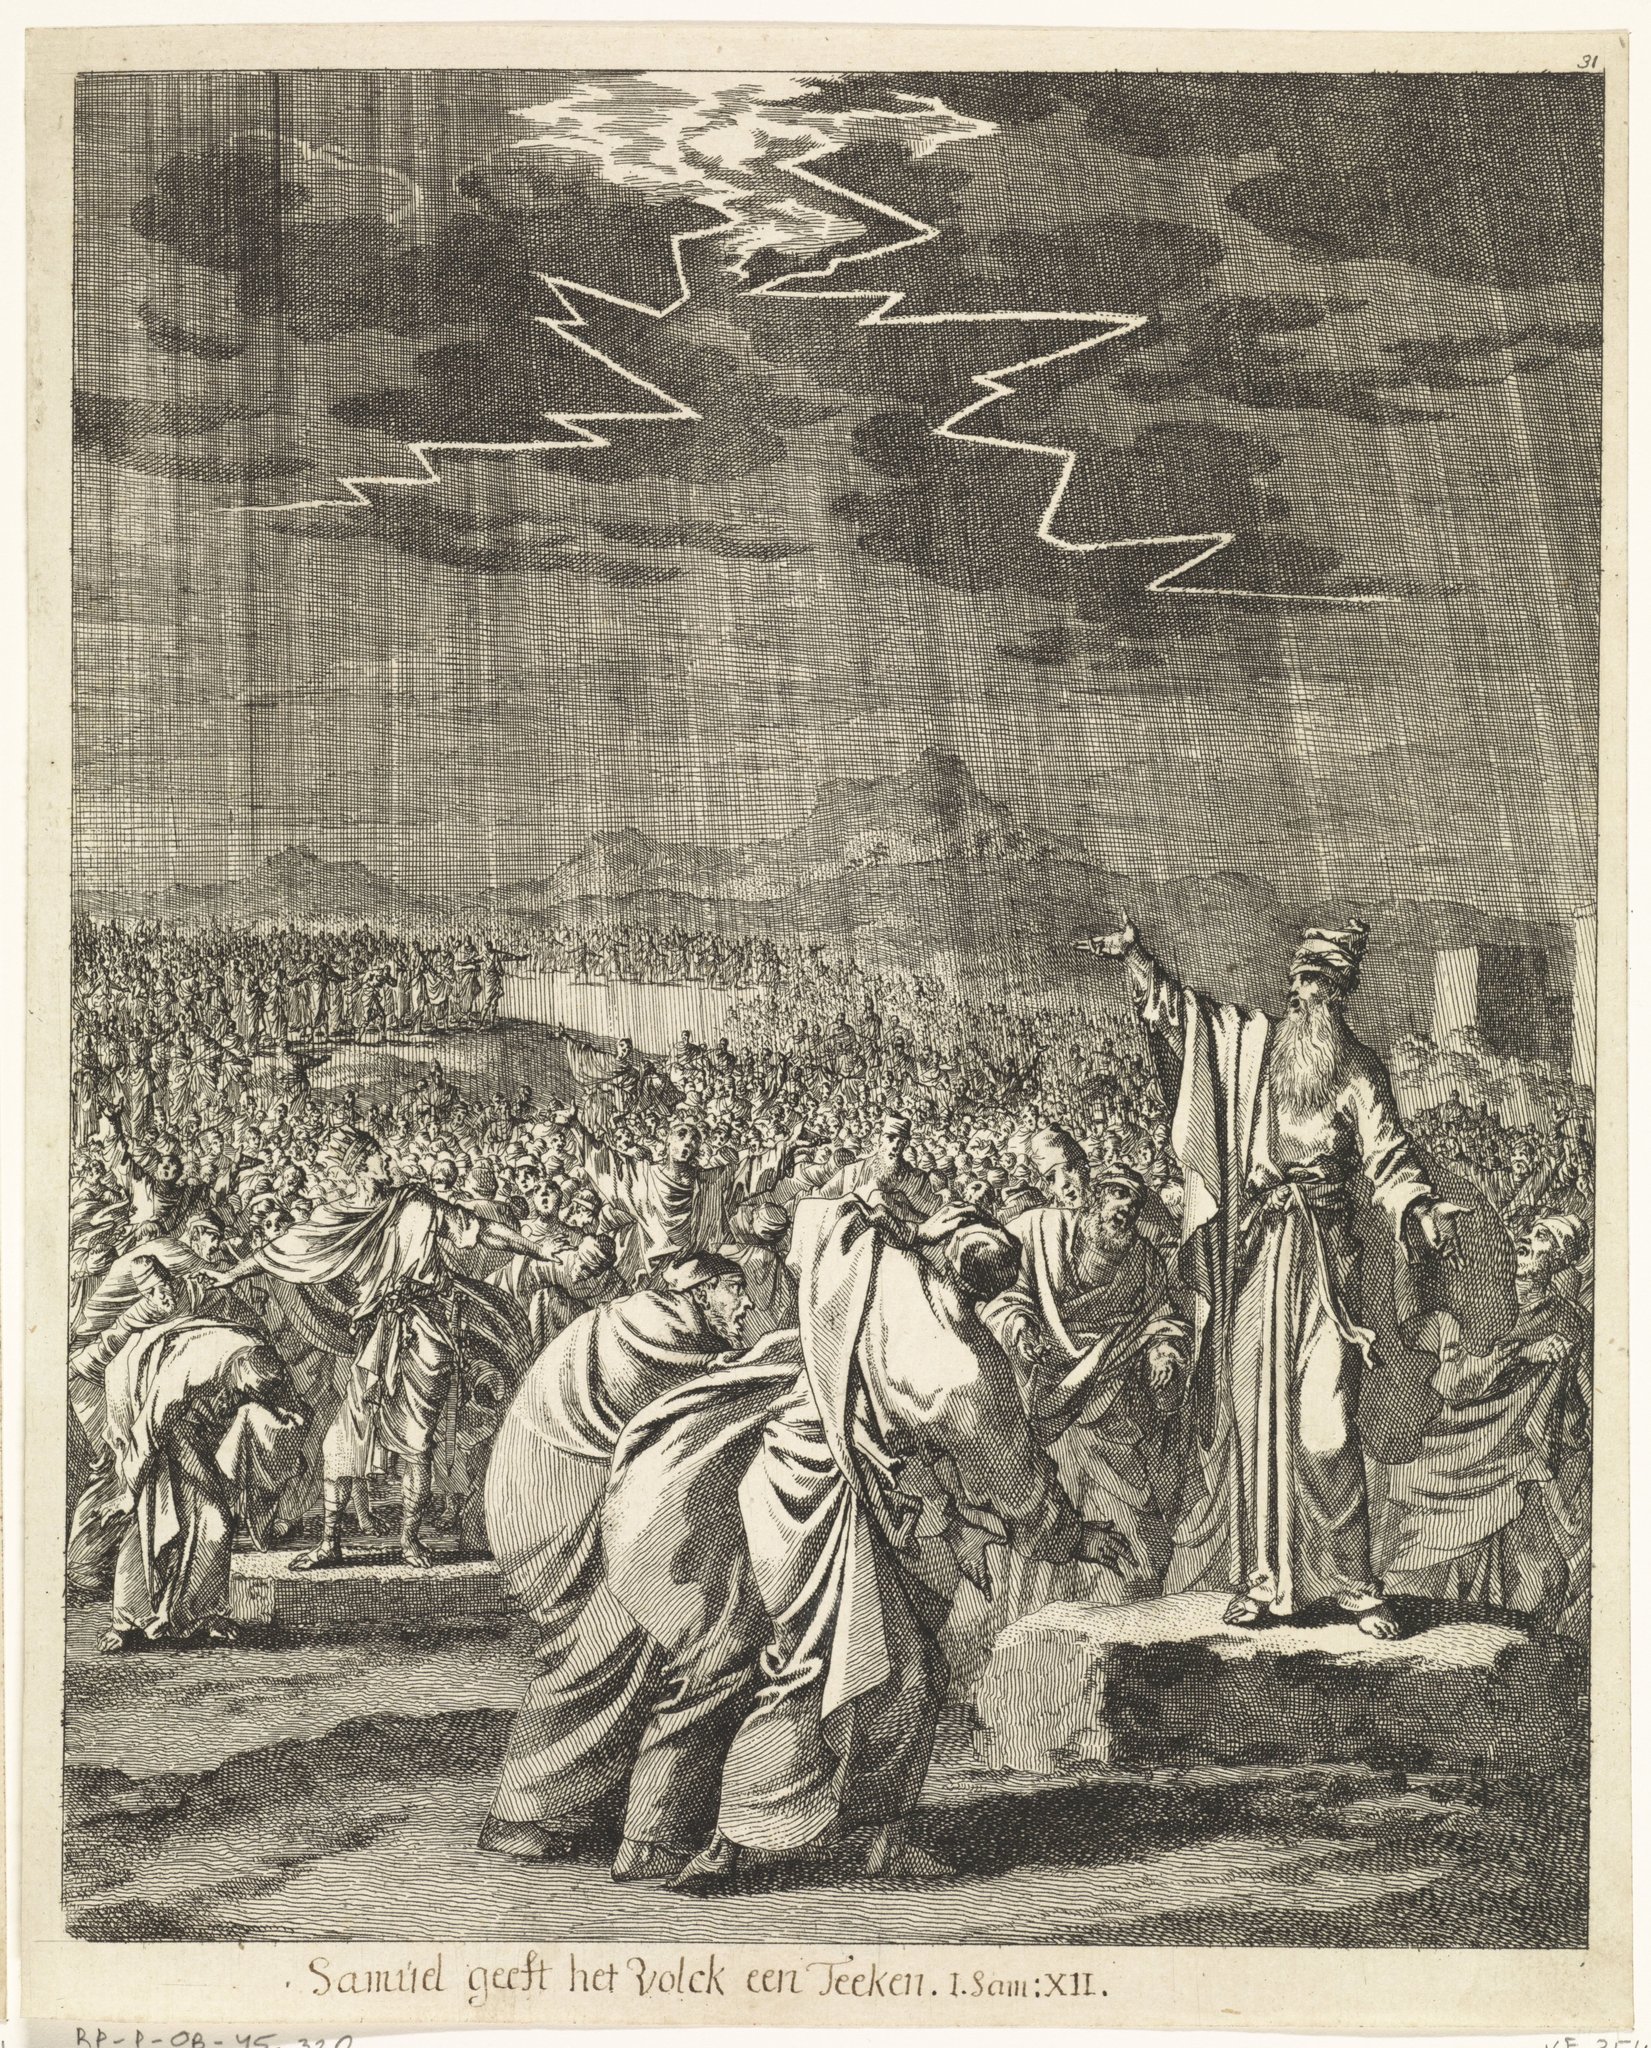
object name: print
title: Samuel en het volk krijgen een teken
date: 1708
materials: paper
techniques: etching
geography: amsterdam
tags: story of samuel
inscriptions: collector's mark: Lugt 2228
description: Proefdruk van een prent welke is opgenomen als illustratie in: Historiae Celebriores Veteris Testamenti. Christoph Weigel, 1708.